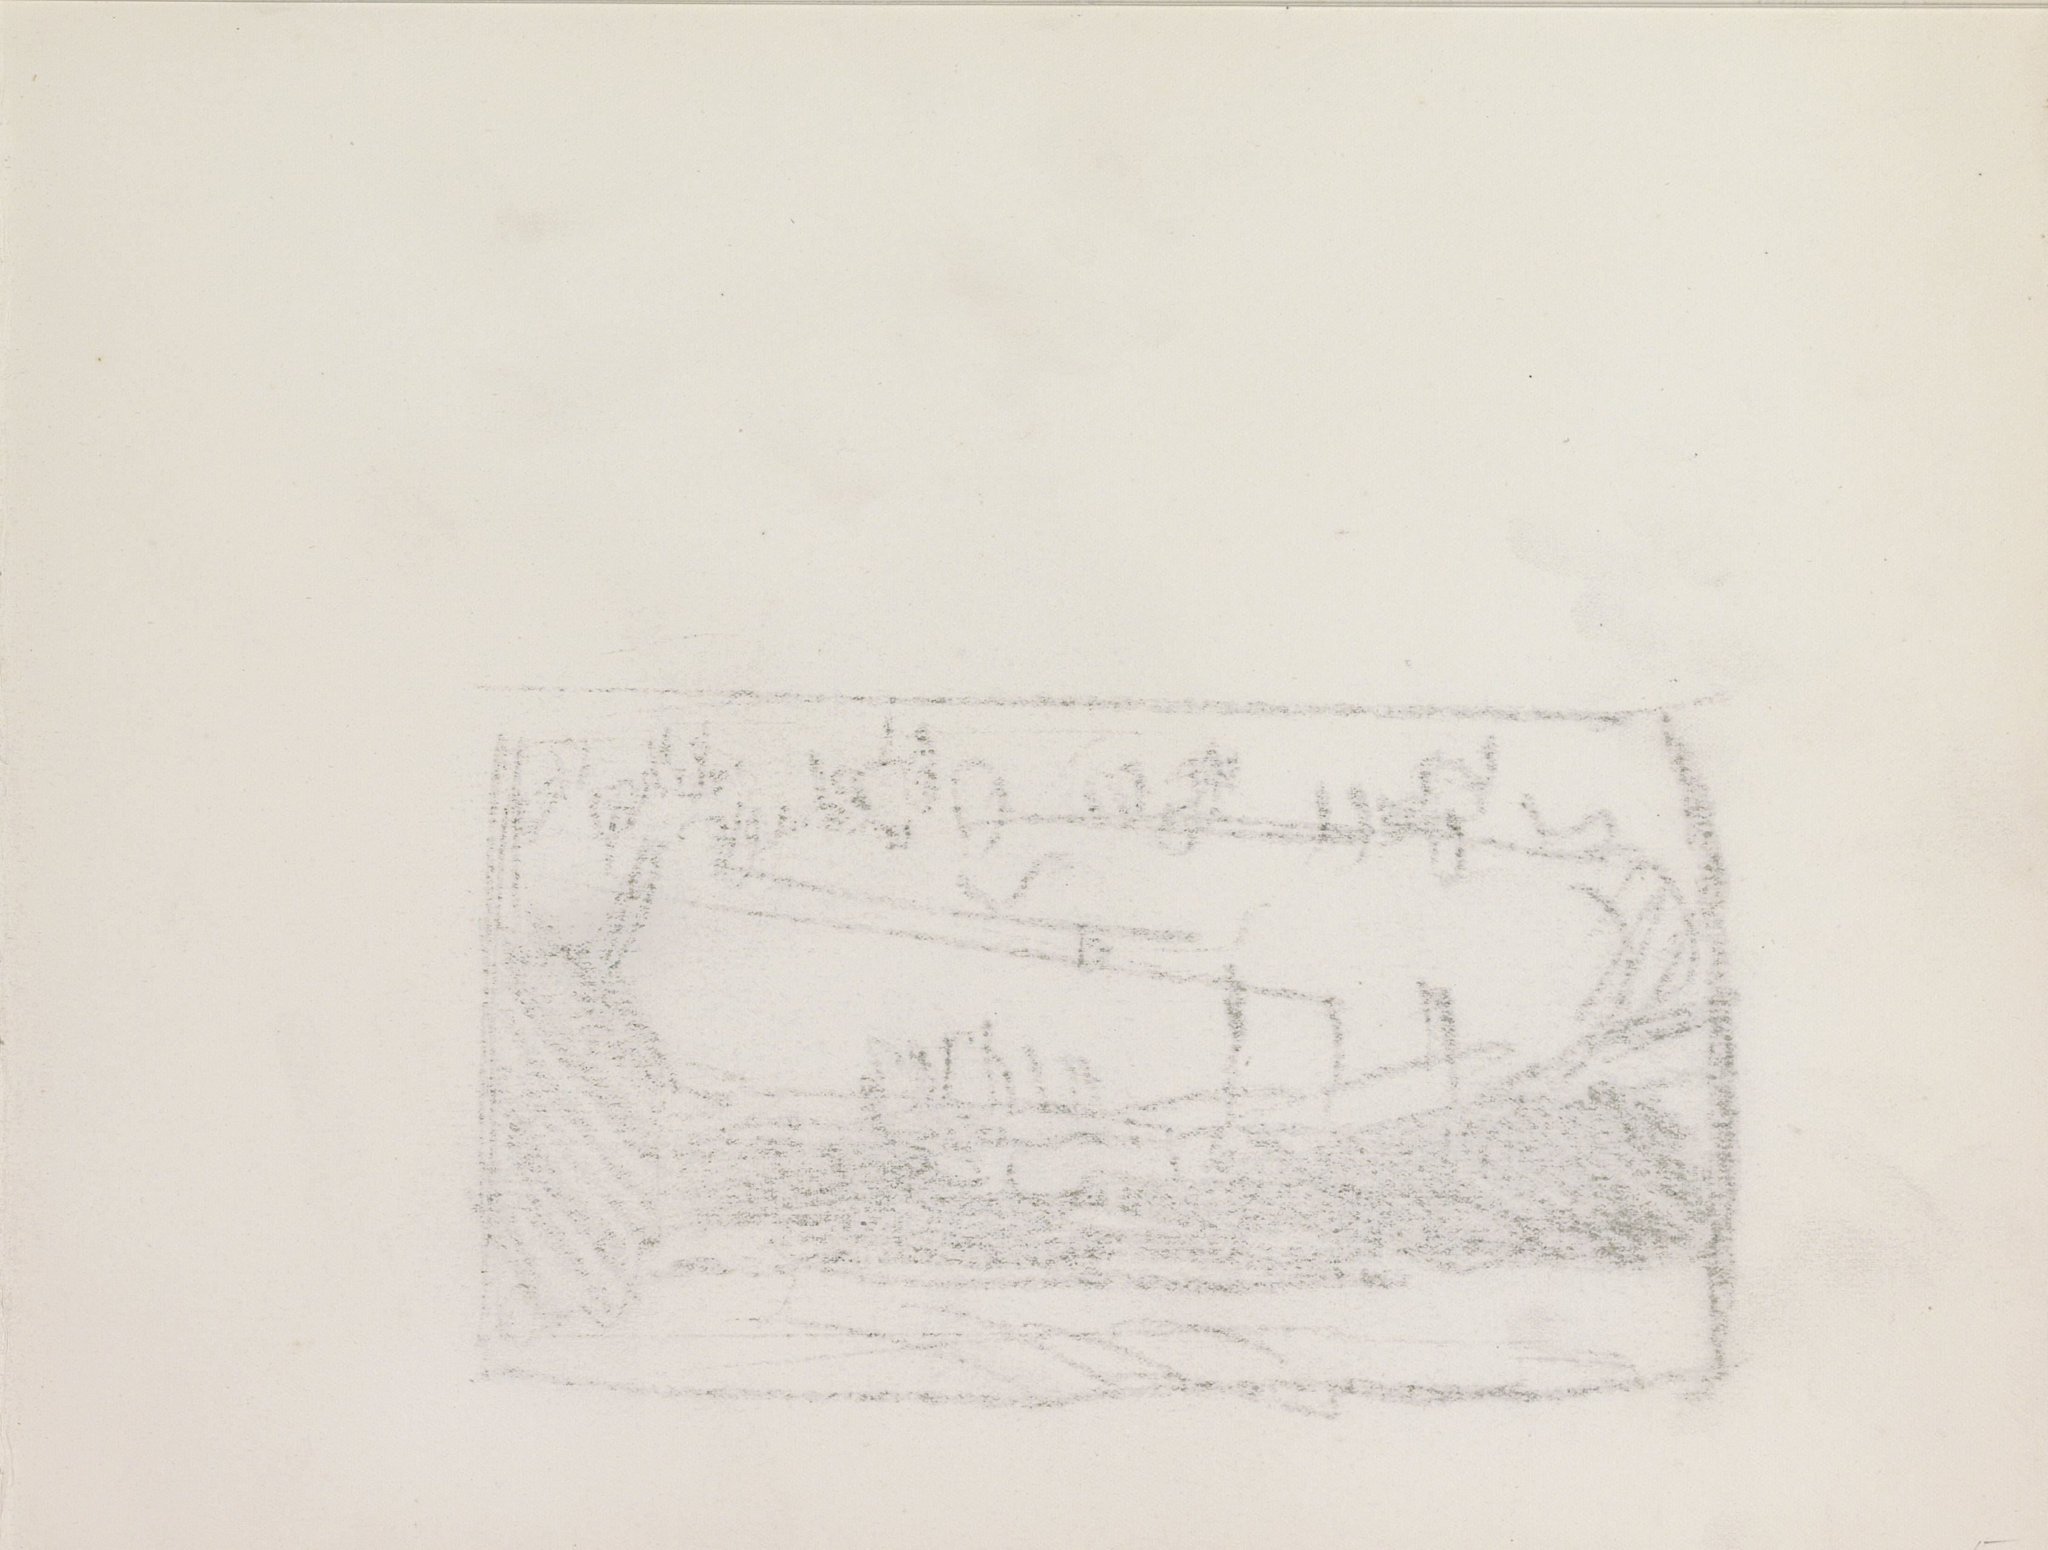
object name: sketchbook leaf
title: Abklatsch van de krijttekening op blad 4 verso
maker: isaac israels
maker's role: draughtsman, painter, print maker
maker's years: 1865-1934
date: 1875-1934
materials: paper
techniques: printmaking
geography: the hague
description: Blad 5 recto uit schetsboek VII met 26 bladen.